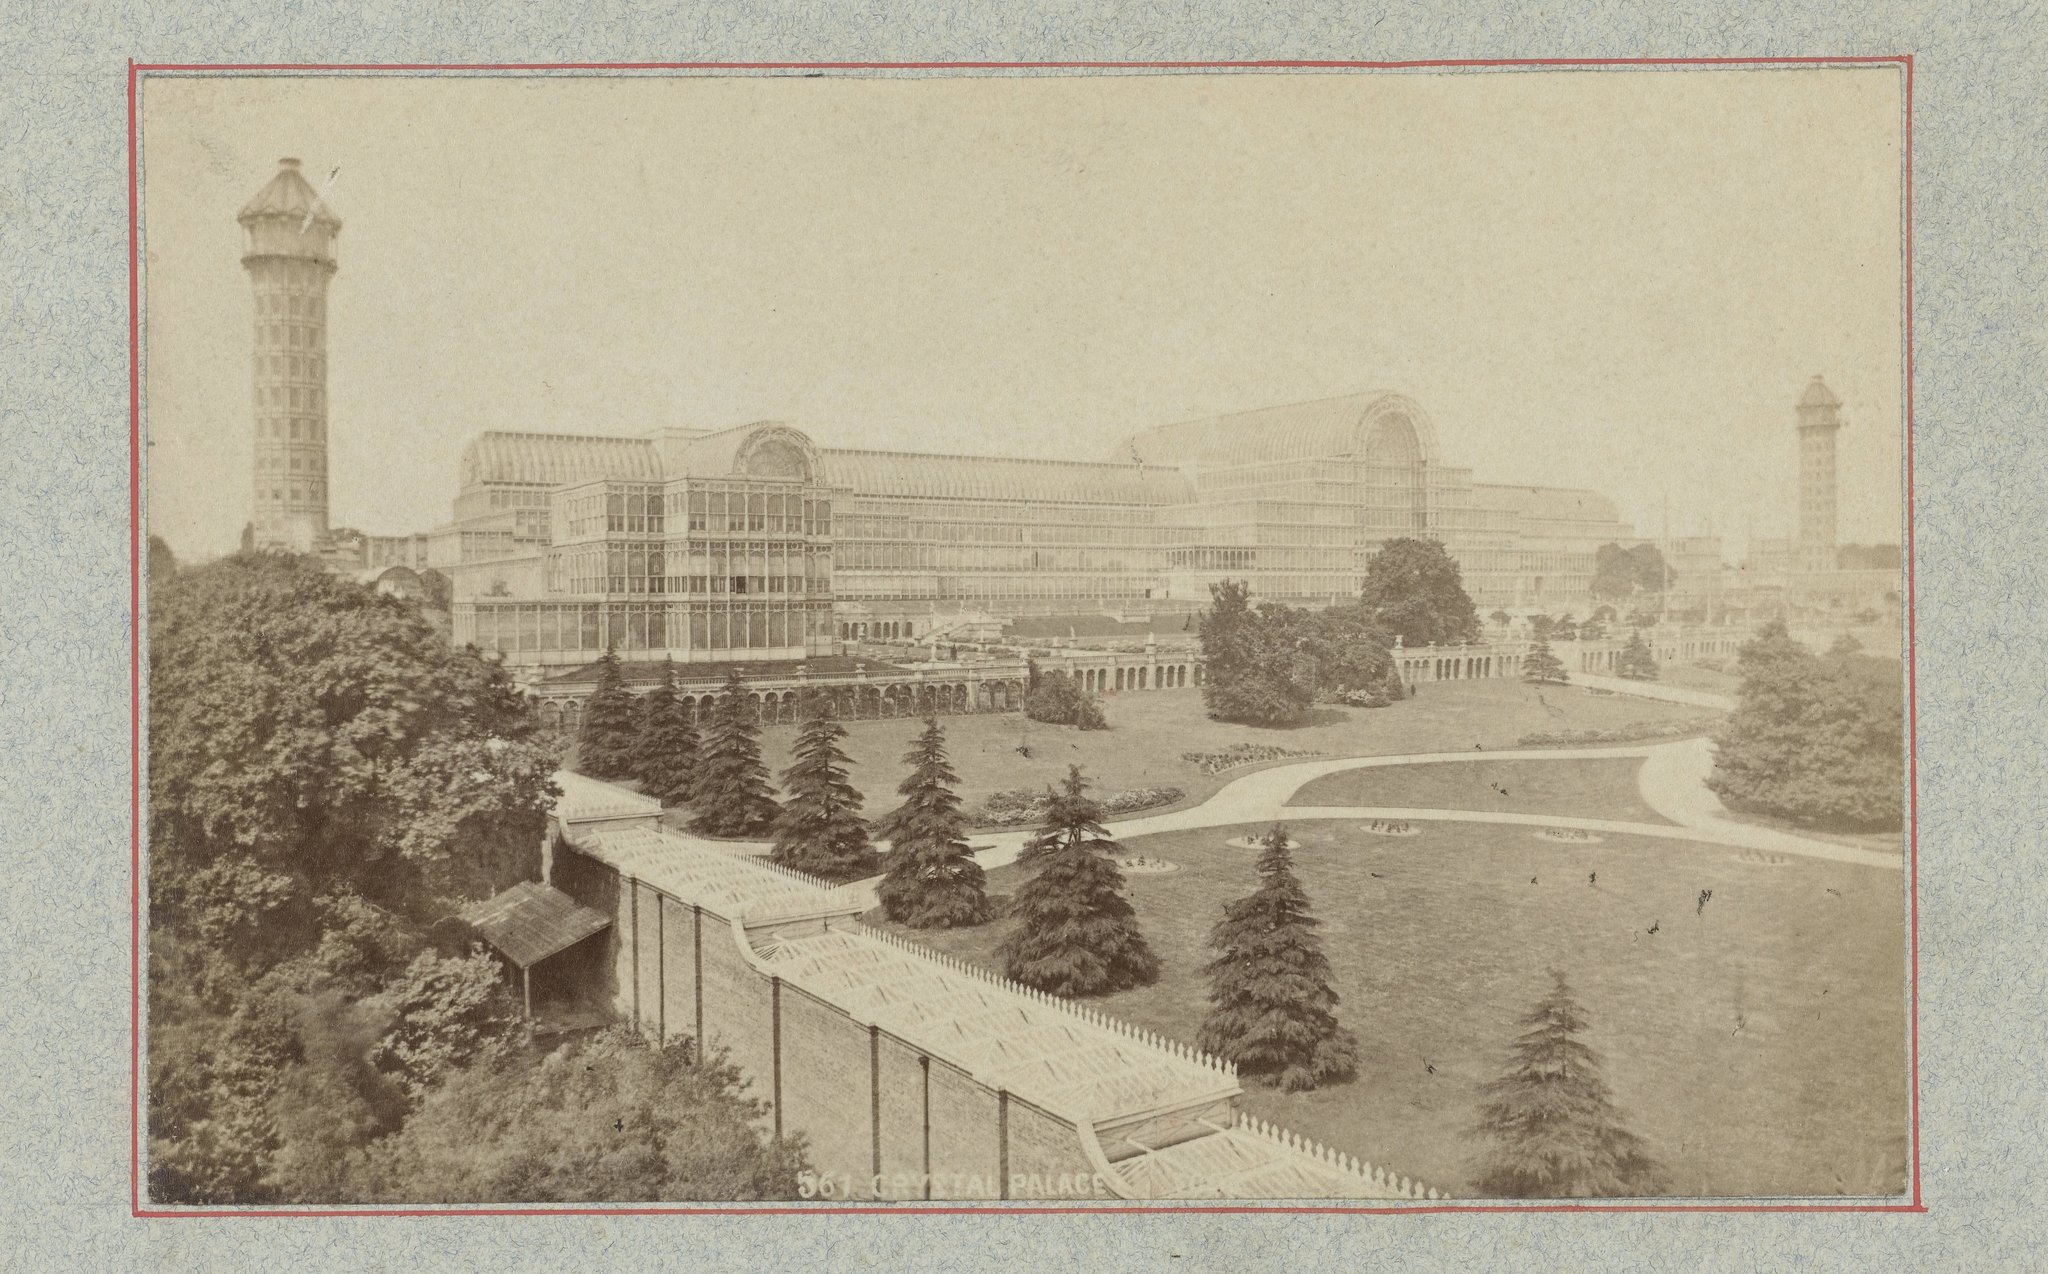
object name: photograph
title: London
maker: francis godolphin osbourne stuart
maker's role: fotograaf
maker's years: 1843-1923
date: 1870-1881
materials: cardboard, paper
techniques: albumen print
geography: sydenham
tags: palace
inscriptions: number: ‘561’